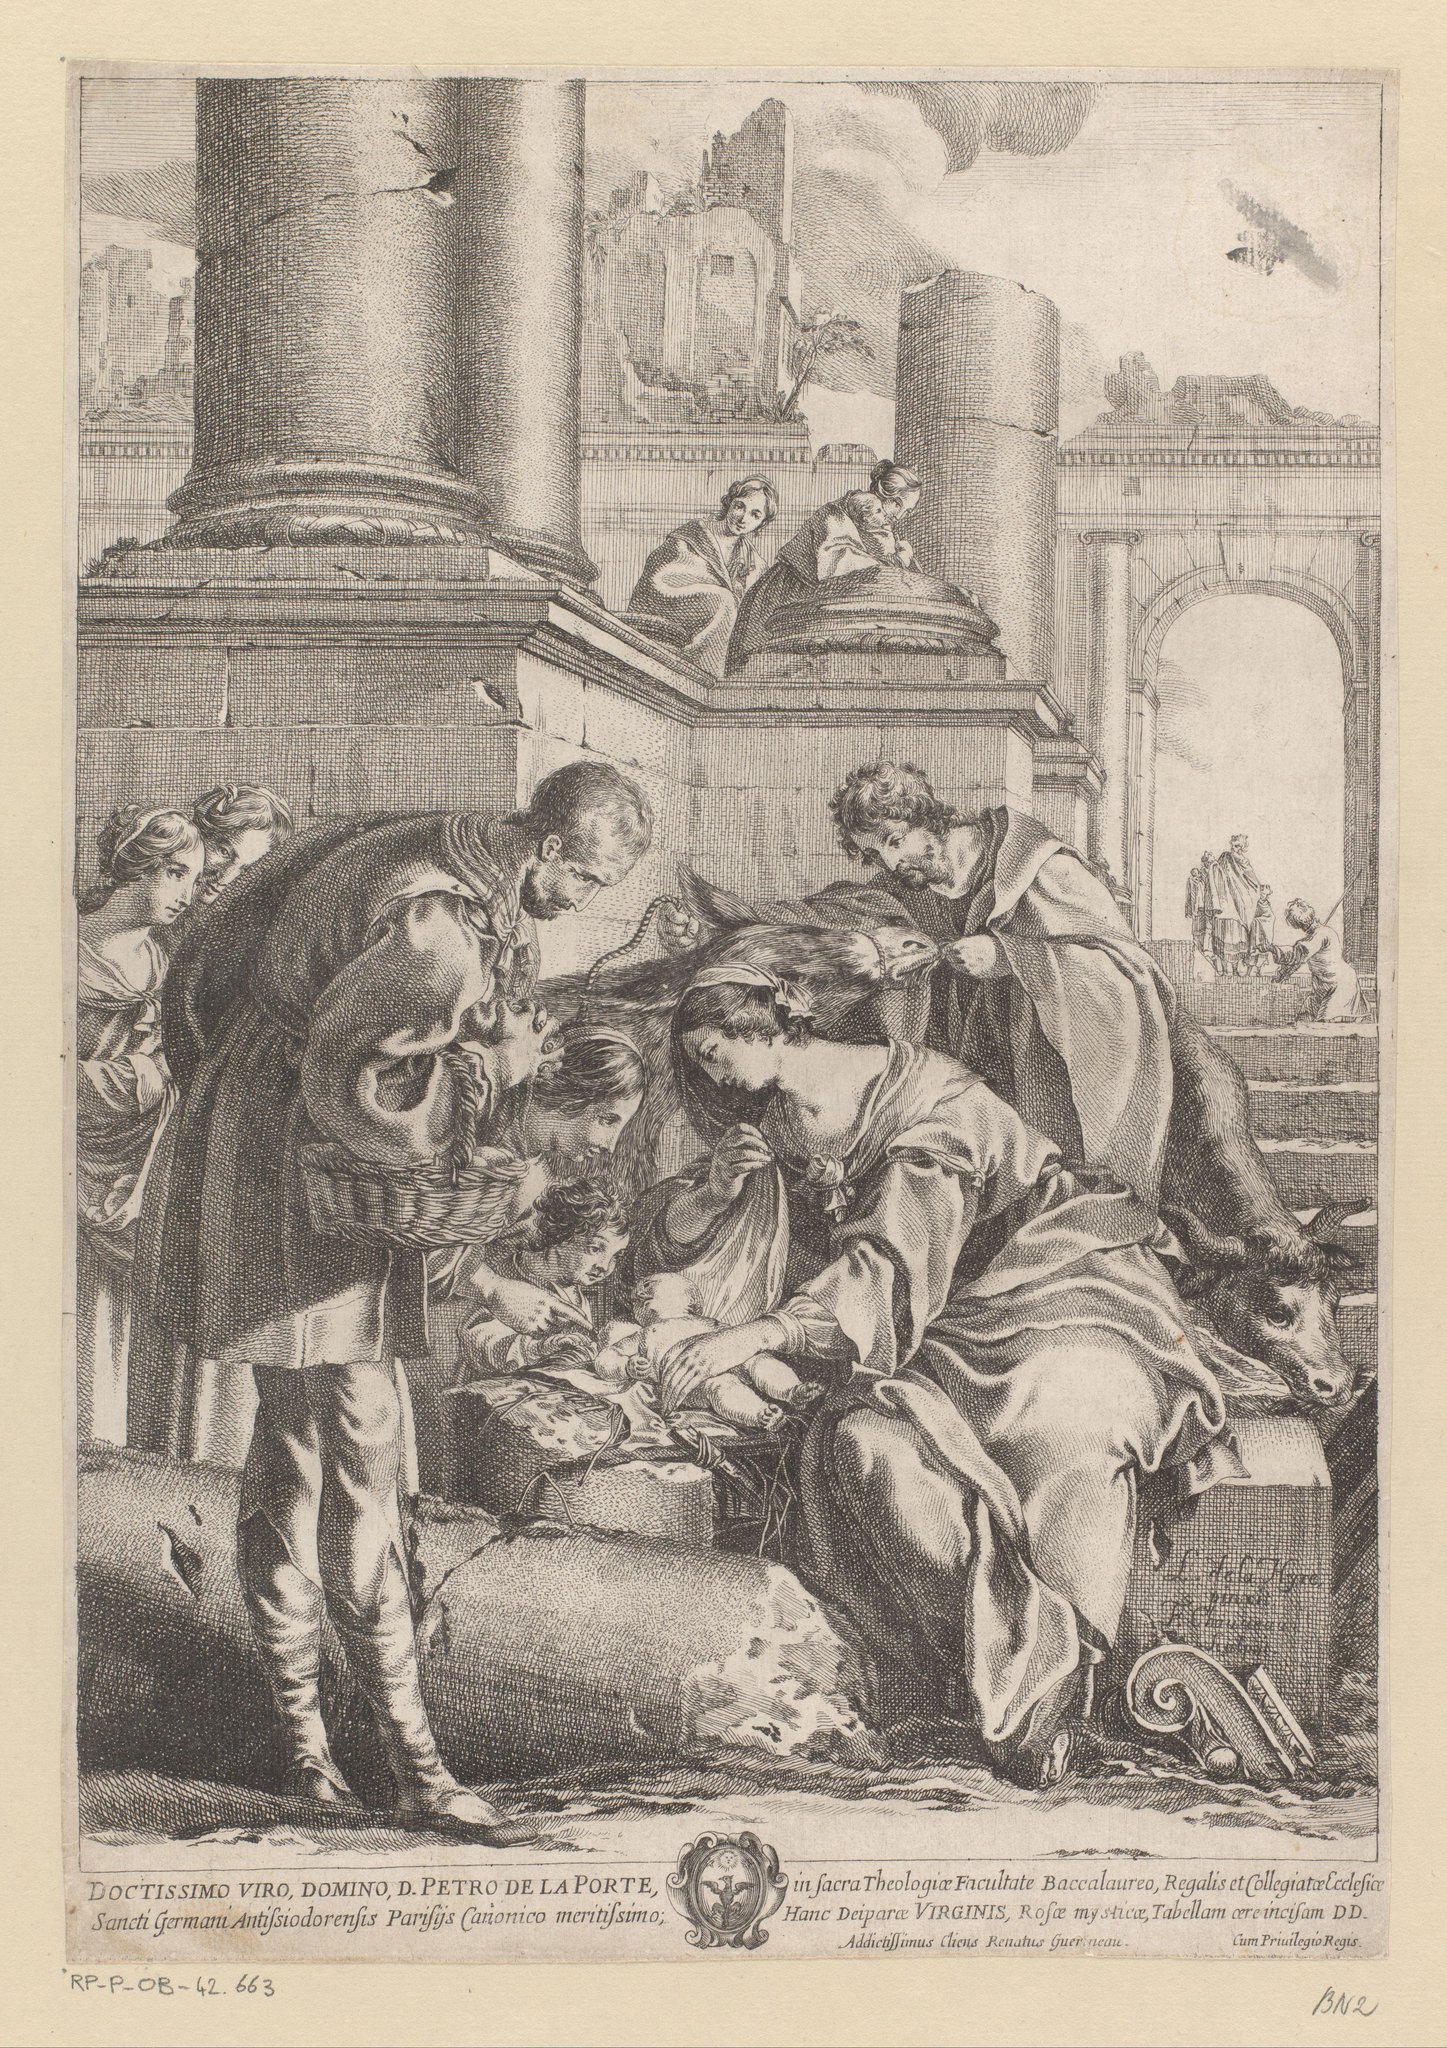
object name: print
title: Aanbidding door de herders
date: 1623-1664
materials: paper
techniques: etching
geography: paris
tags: adoration of the christ-child by the shepherds; mary and joseph present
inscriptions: collector's mark: Lugt 240